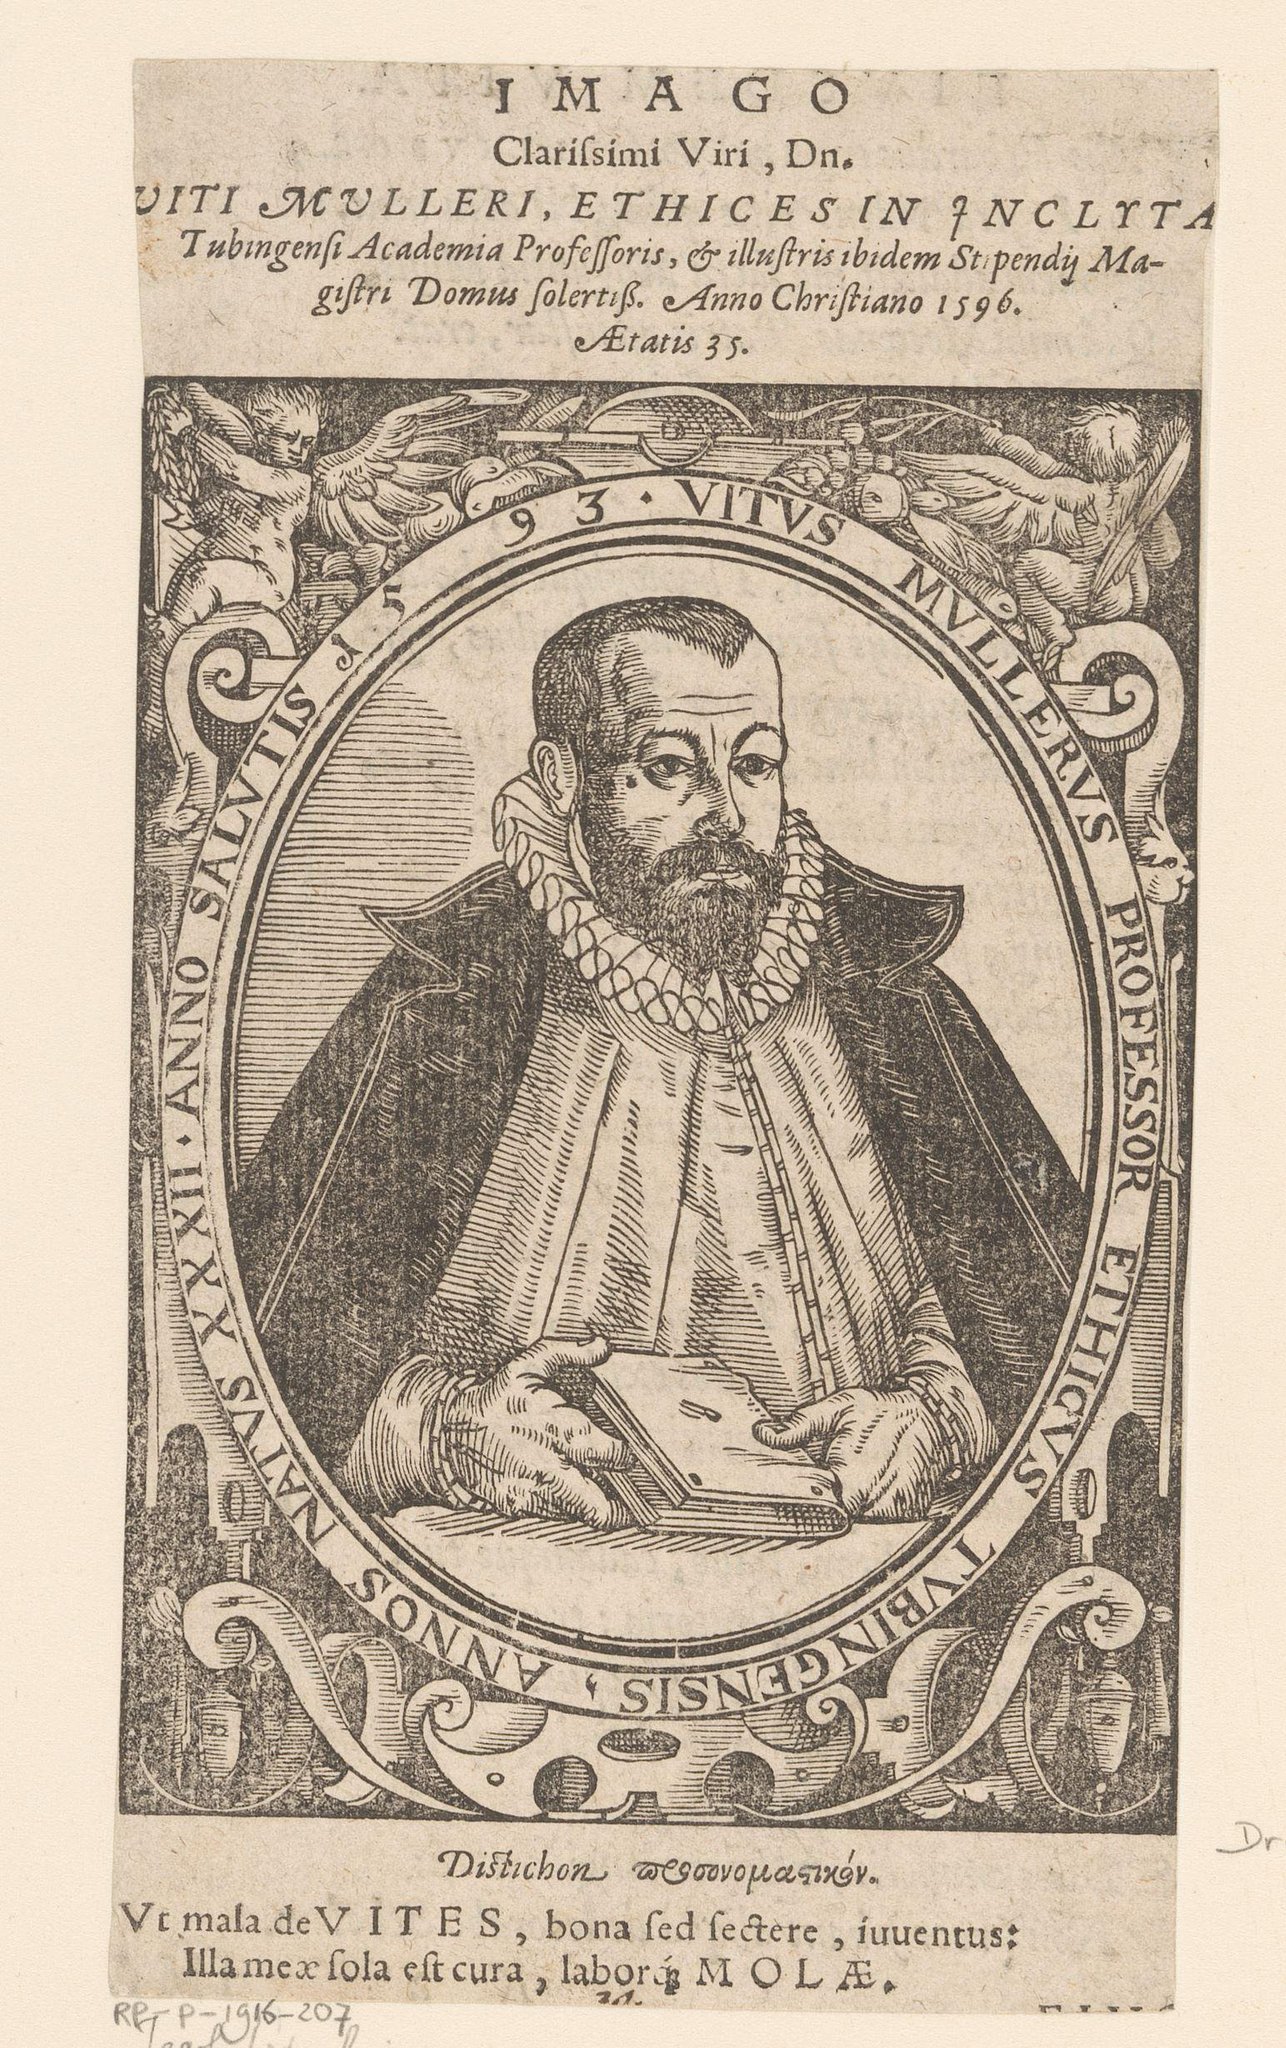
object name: book illustration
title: Portret van Veit Müller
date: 1596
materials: paper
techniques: letterpress printing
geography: tübingen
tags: historical persons, book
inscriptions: collector's mark: Lugt 2228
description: Prent gebruikt voor de publicatie: Cellius, Erhard. Imagines professorum Tubingensium. Tübingen: Erhard Cellius, 1596, p. [86].